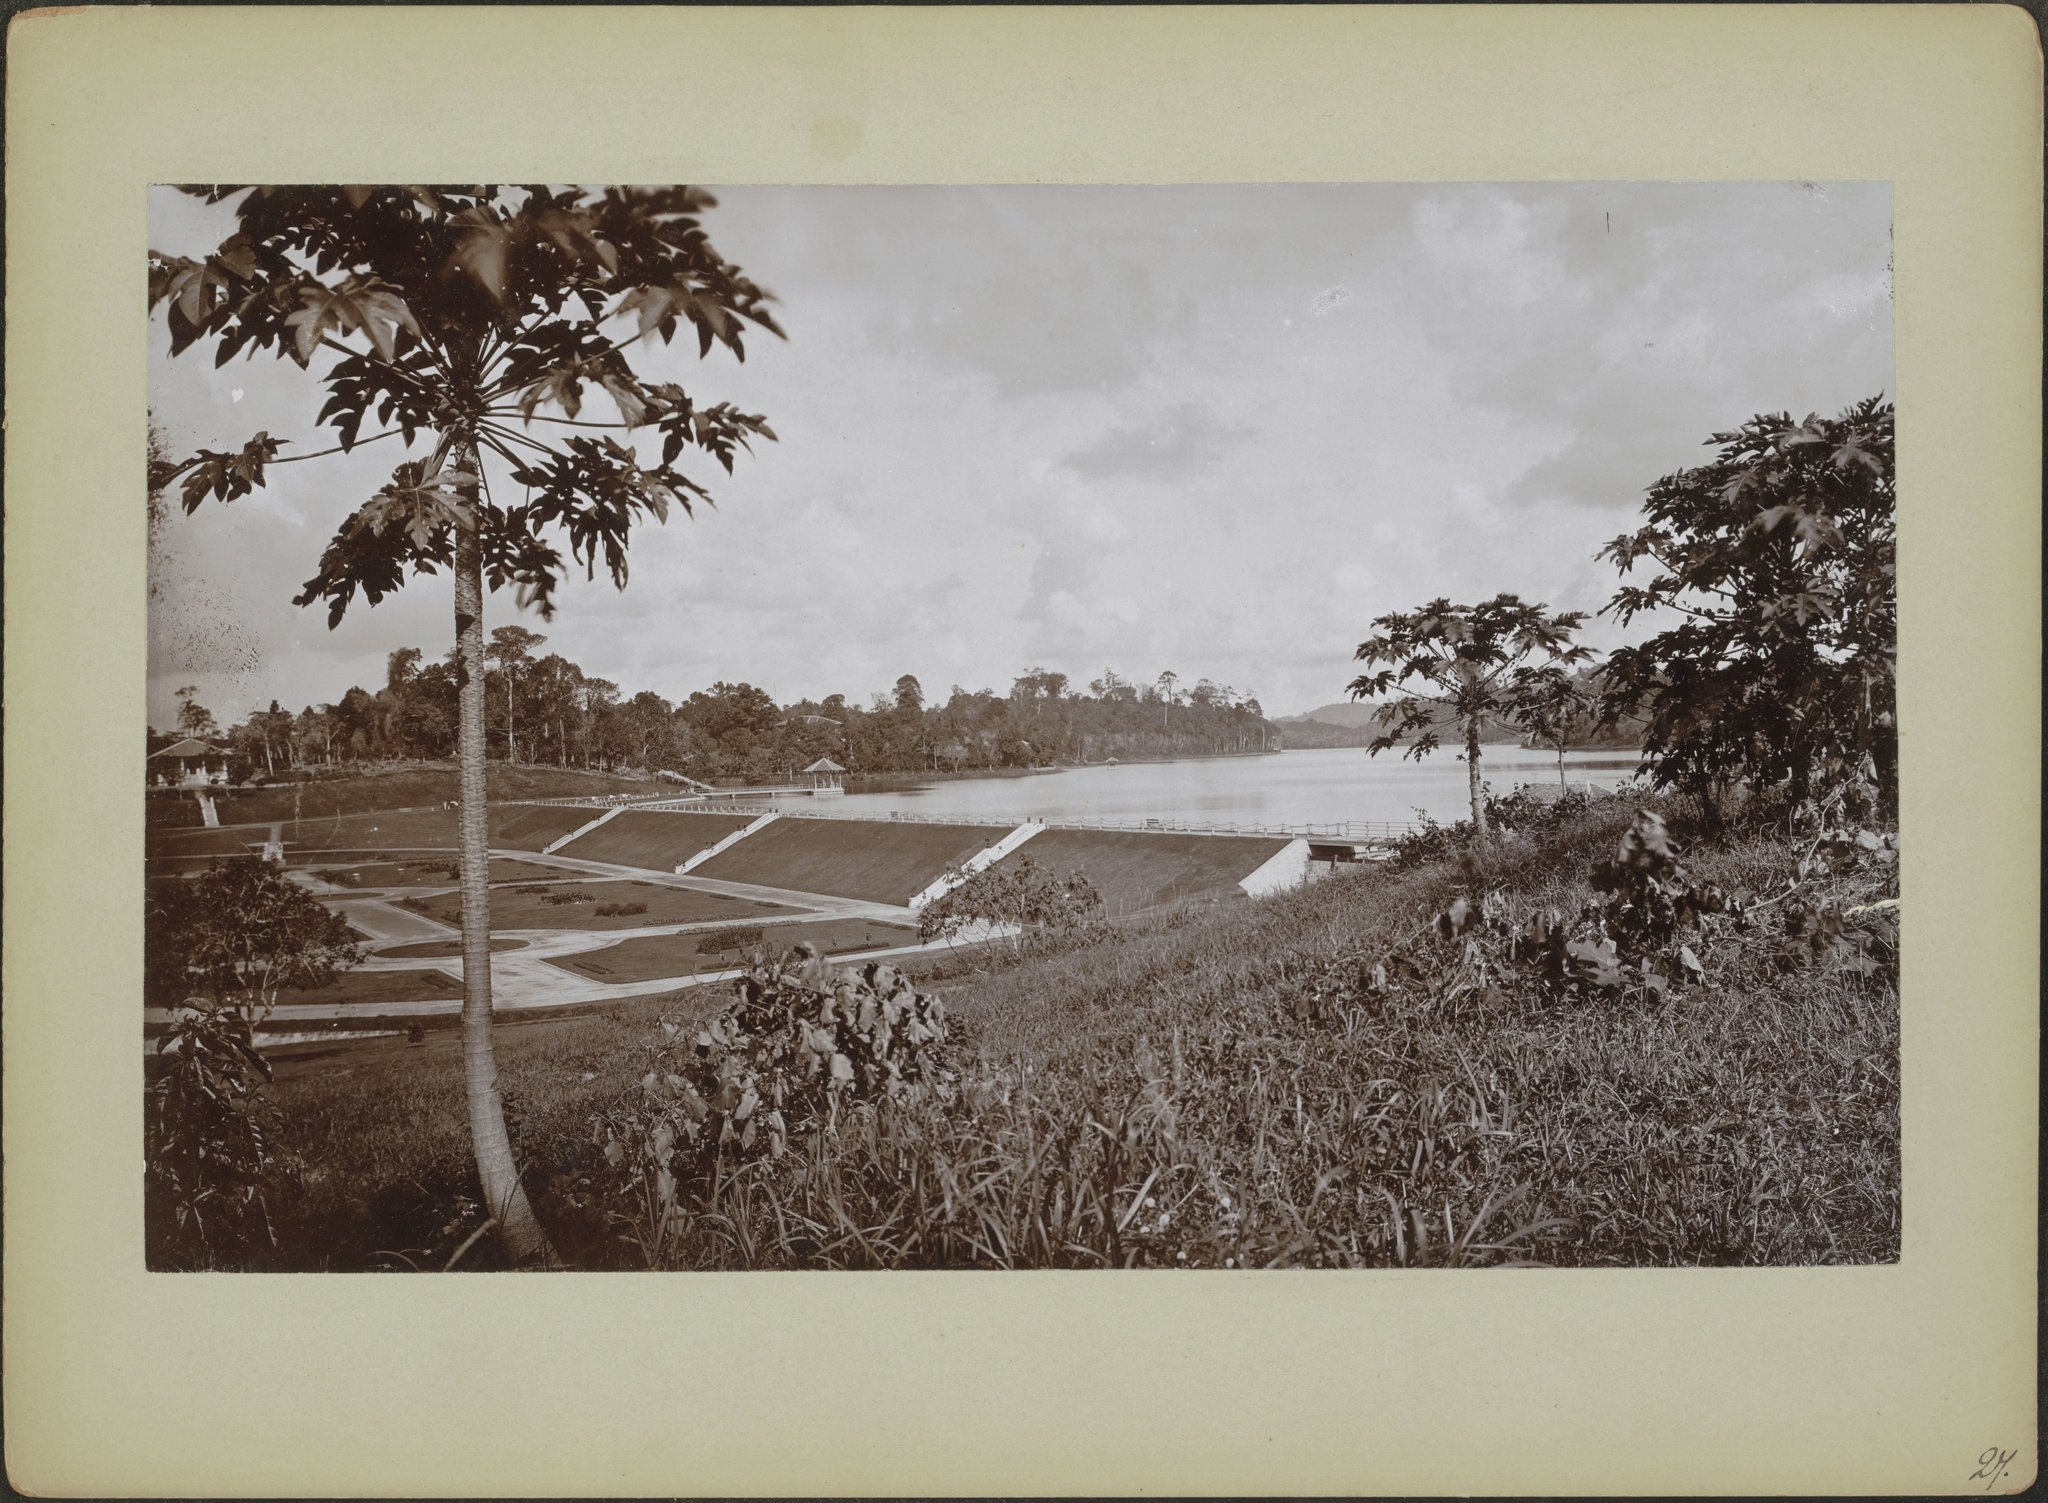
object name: photograph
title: Waterwerken in Singapore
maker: Anonymous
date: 1870-1910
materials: cardboard, paper, photographic support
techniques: collodion silver print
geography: singapore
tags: sluice, weir, singapore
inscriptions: inscription: ‘Waterwerken. Singapore’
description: Onderdeel van Reisalbum met foto's van bezienswaardigheden in Marseille, Port Said, Aden, Bombay, Colombo, Singapore en Nederlands-Indië.